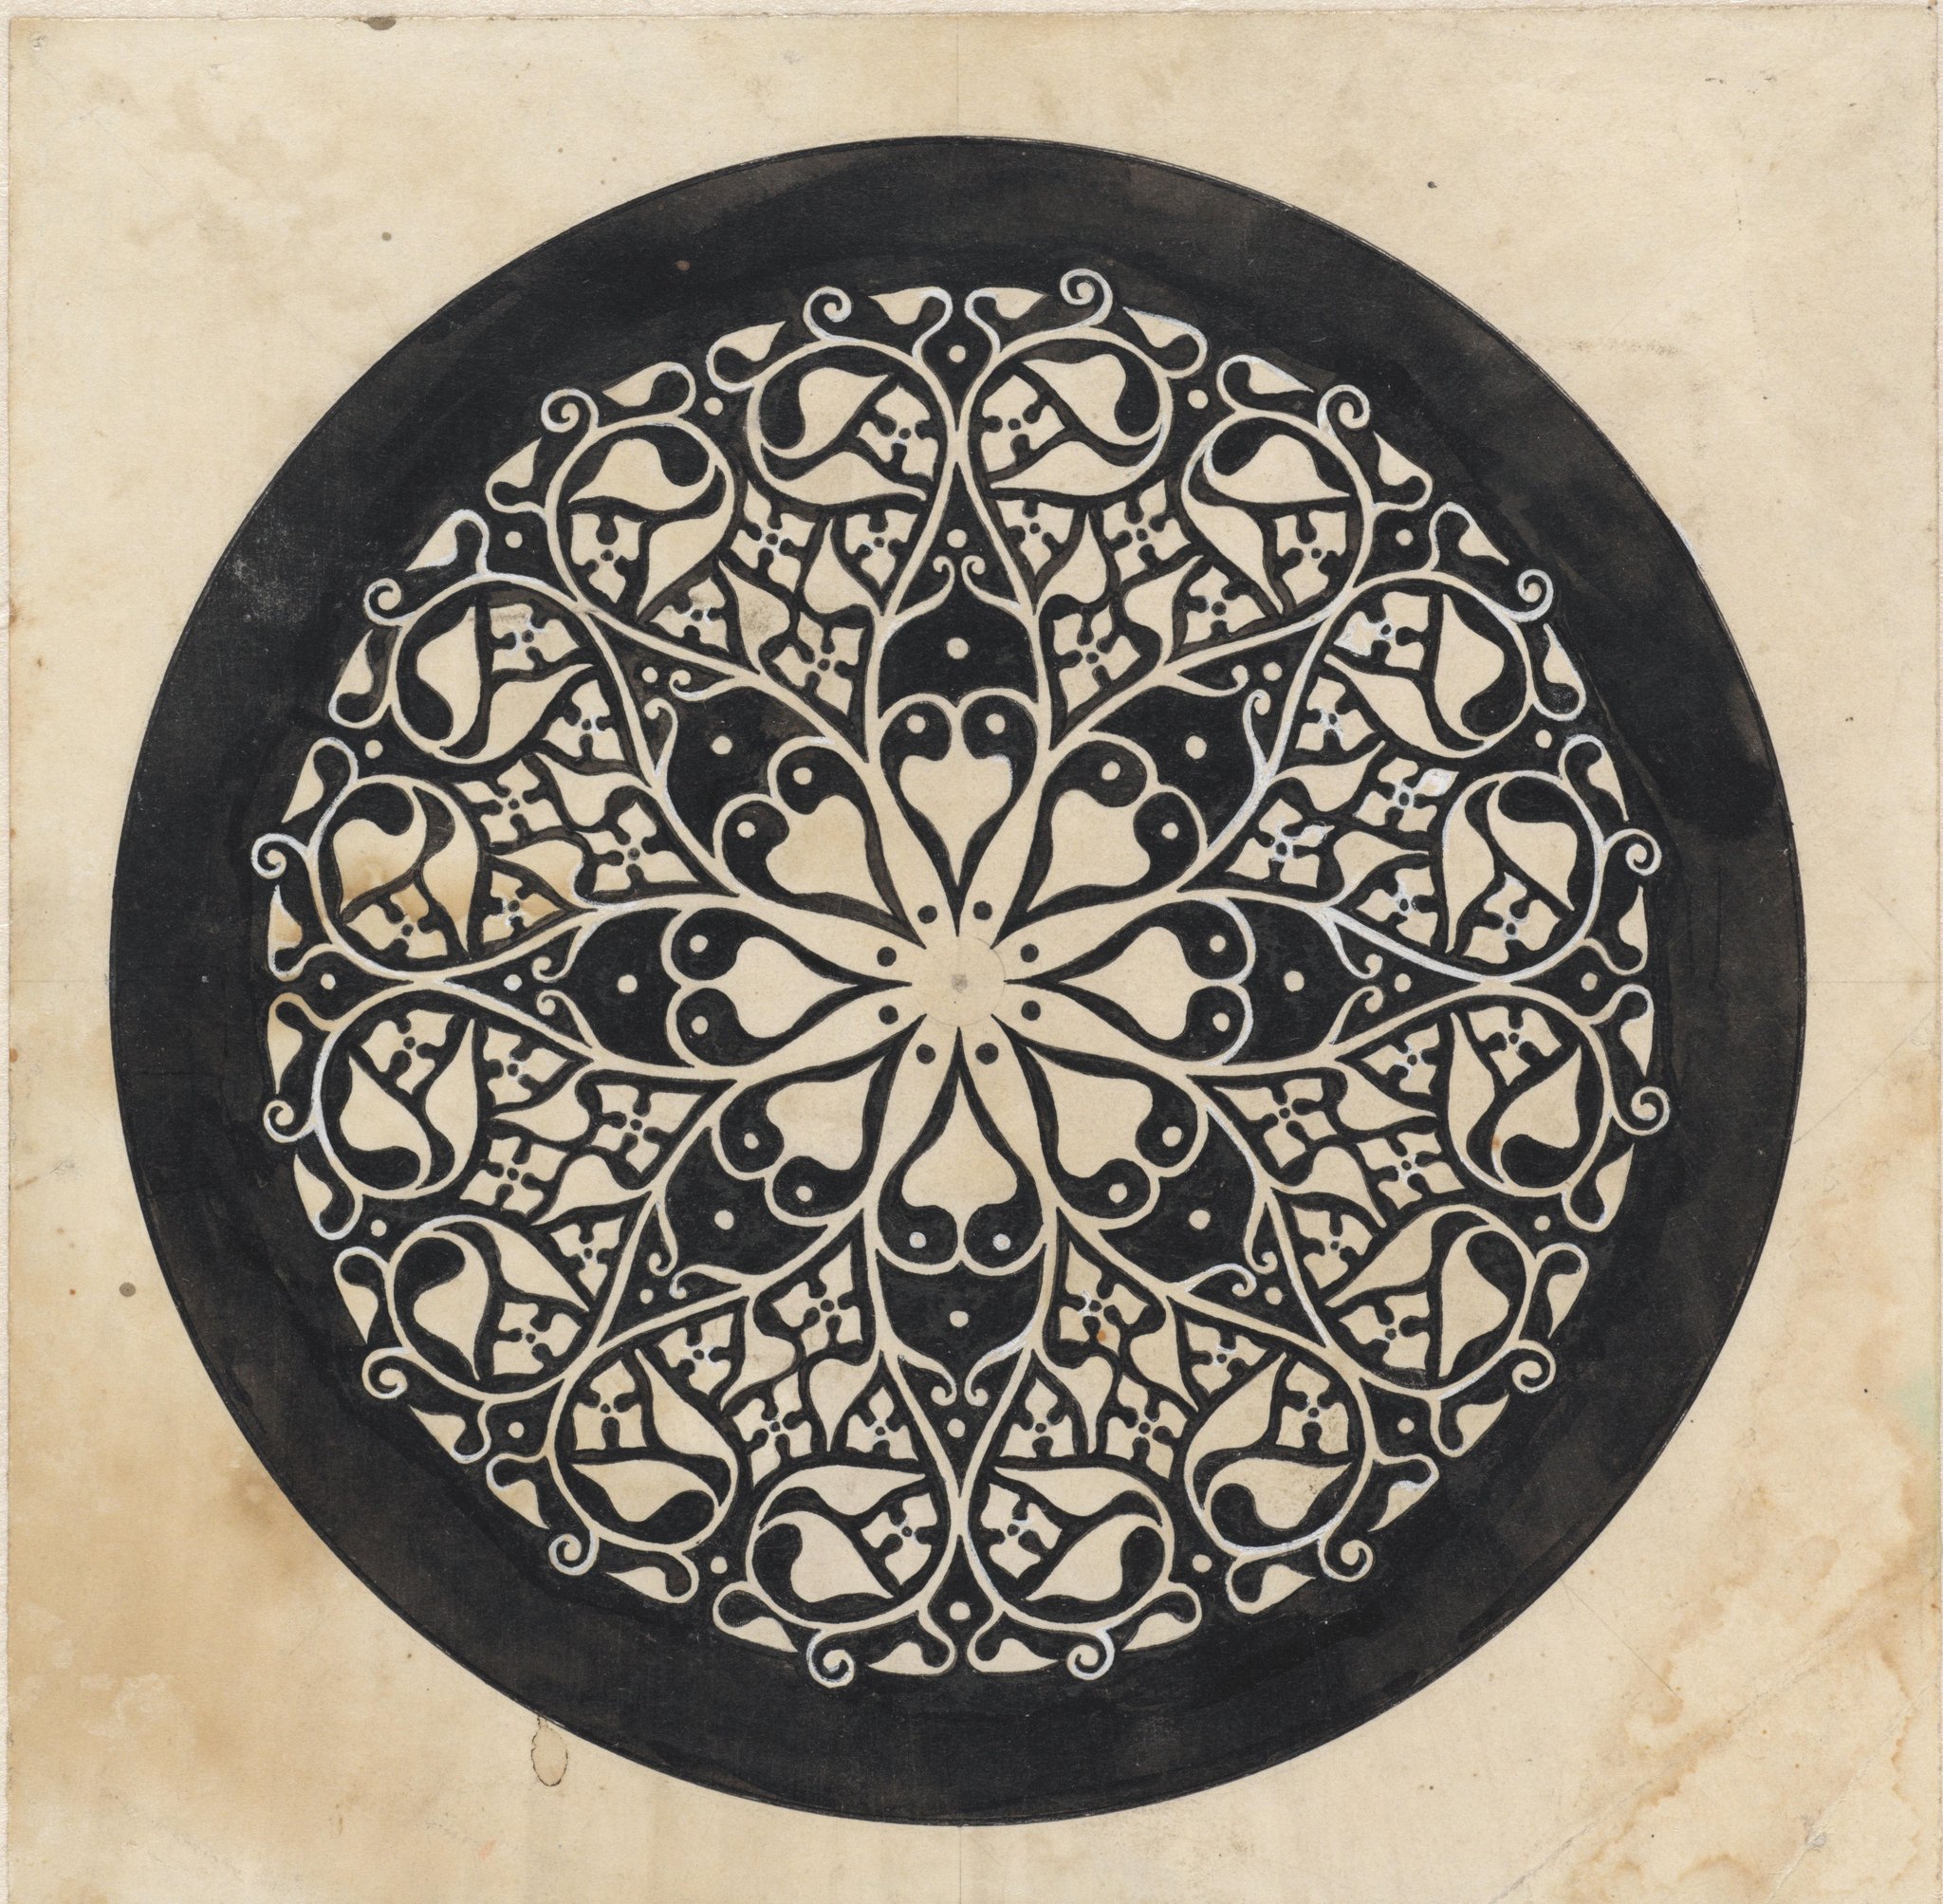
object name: drawing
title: Ornamentale vlakvulling in een cirkel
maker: theo nieuwenhuis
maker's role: designer, draughtsman, print maker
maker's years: 1866-1951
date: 1876-1951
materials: paint, paper, pencil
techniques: brush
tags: ornaments ~ art